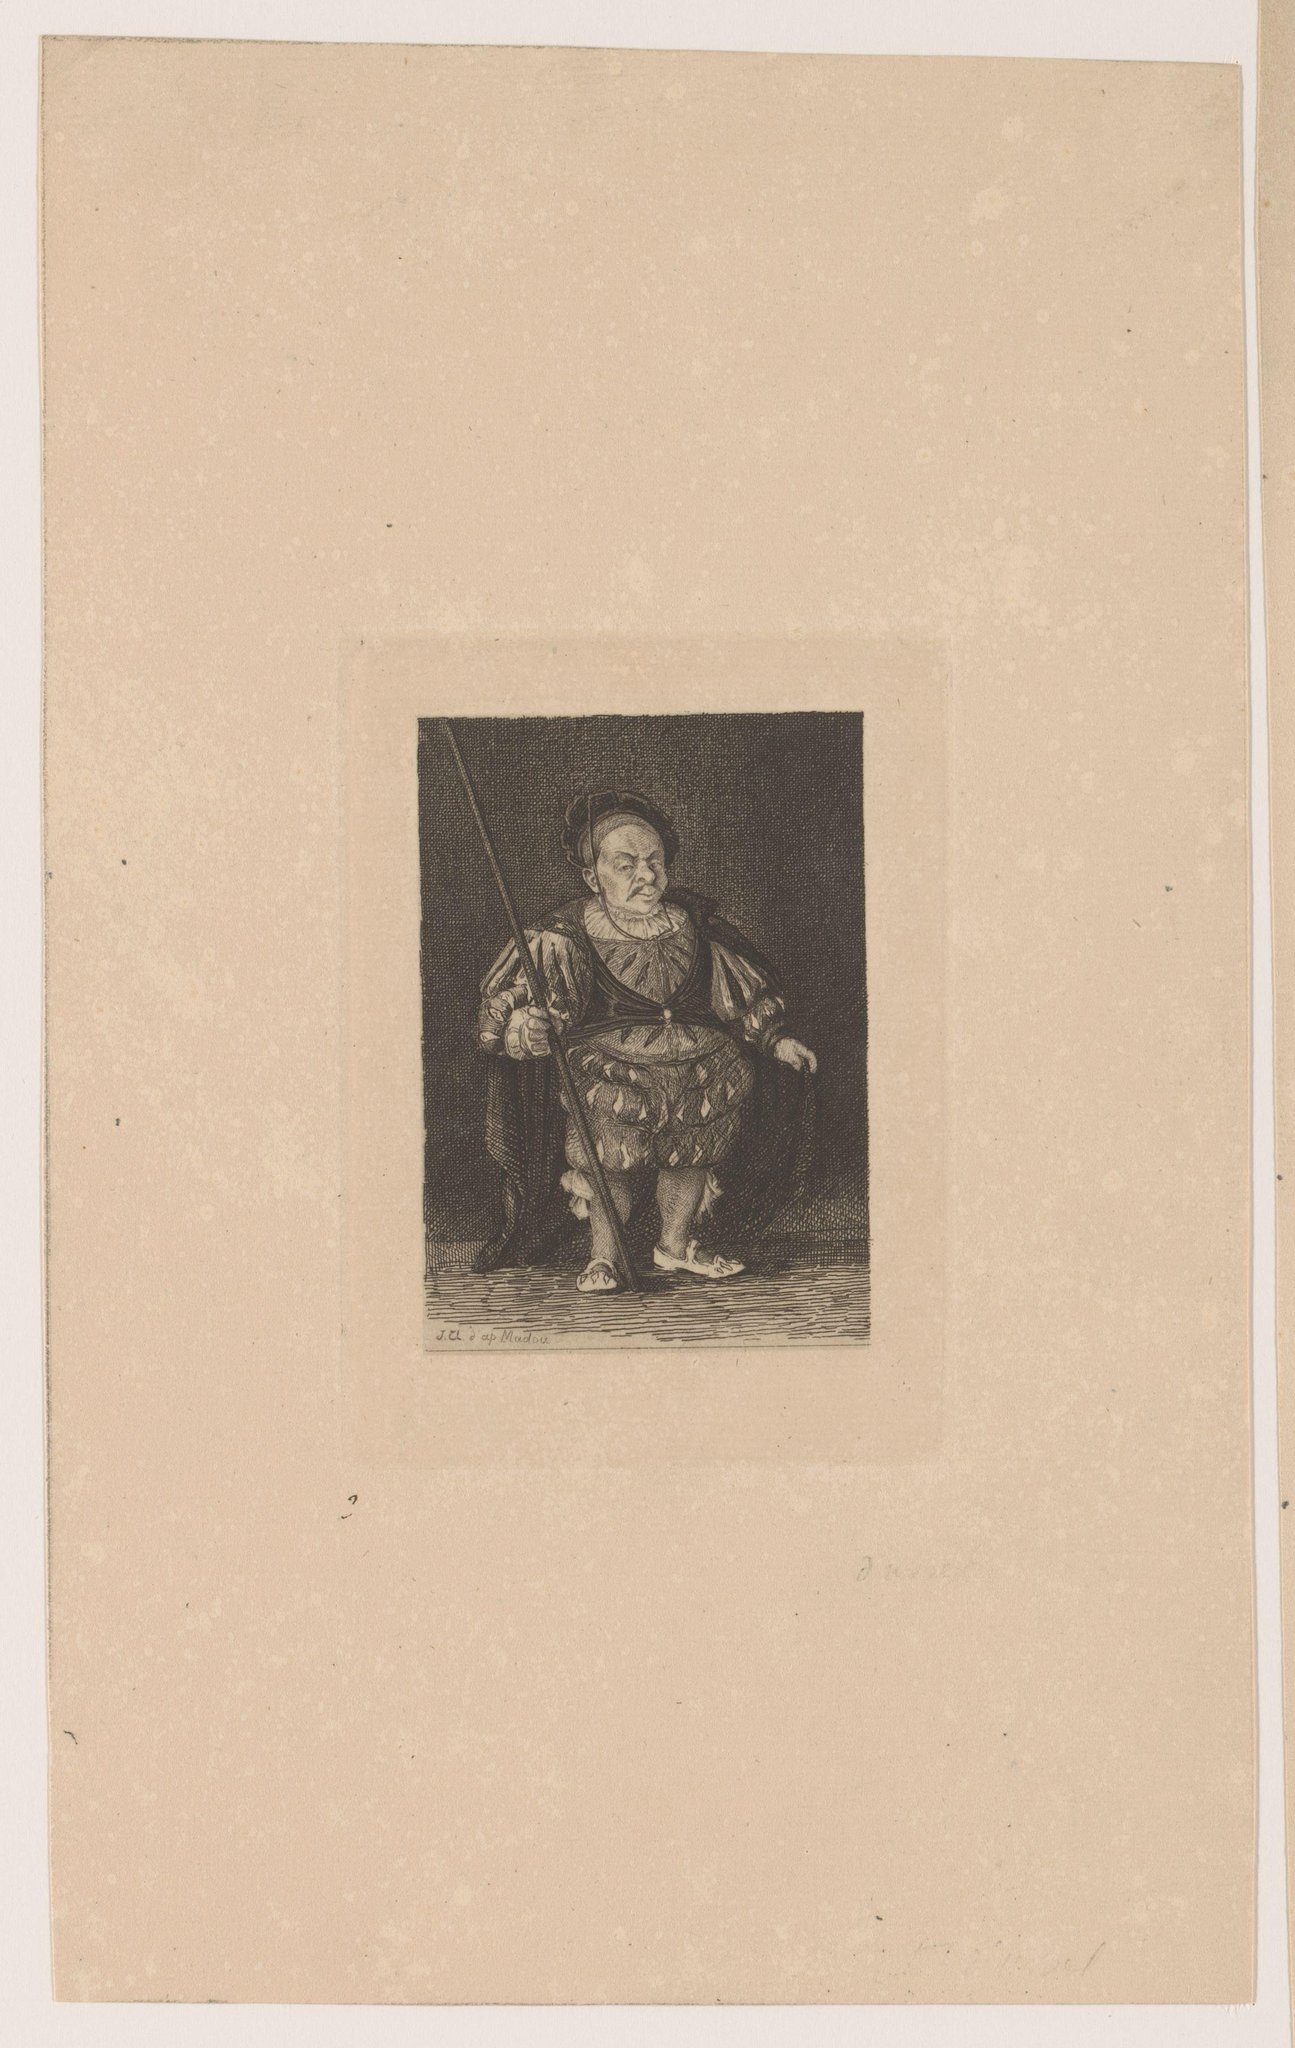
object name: print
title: Cahier d'études eau-fortes originales et inédites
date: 1875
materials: paper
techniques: drypoint, etching, intaglio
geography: brussels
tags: court jester, court fool, buffoon (in general) (german: 'schalksnarr'), little people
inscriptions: collector's mark: Lugt 2228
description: Prent uit: Rops, Félicien (red.), Cahier d'études eaux-fortes originales et inédites. Brussel: Felix Callewaert père, 1875. Het betreft hier een afgesneden blad.